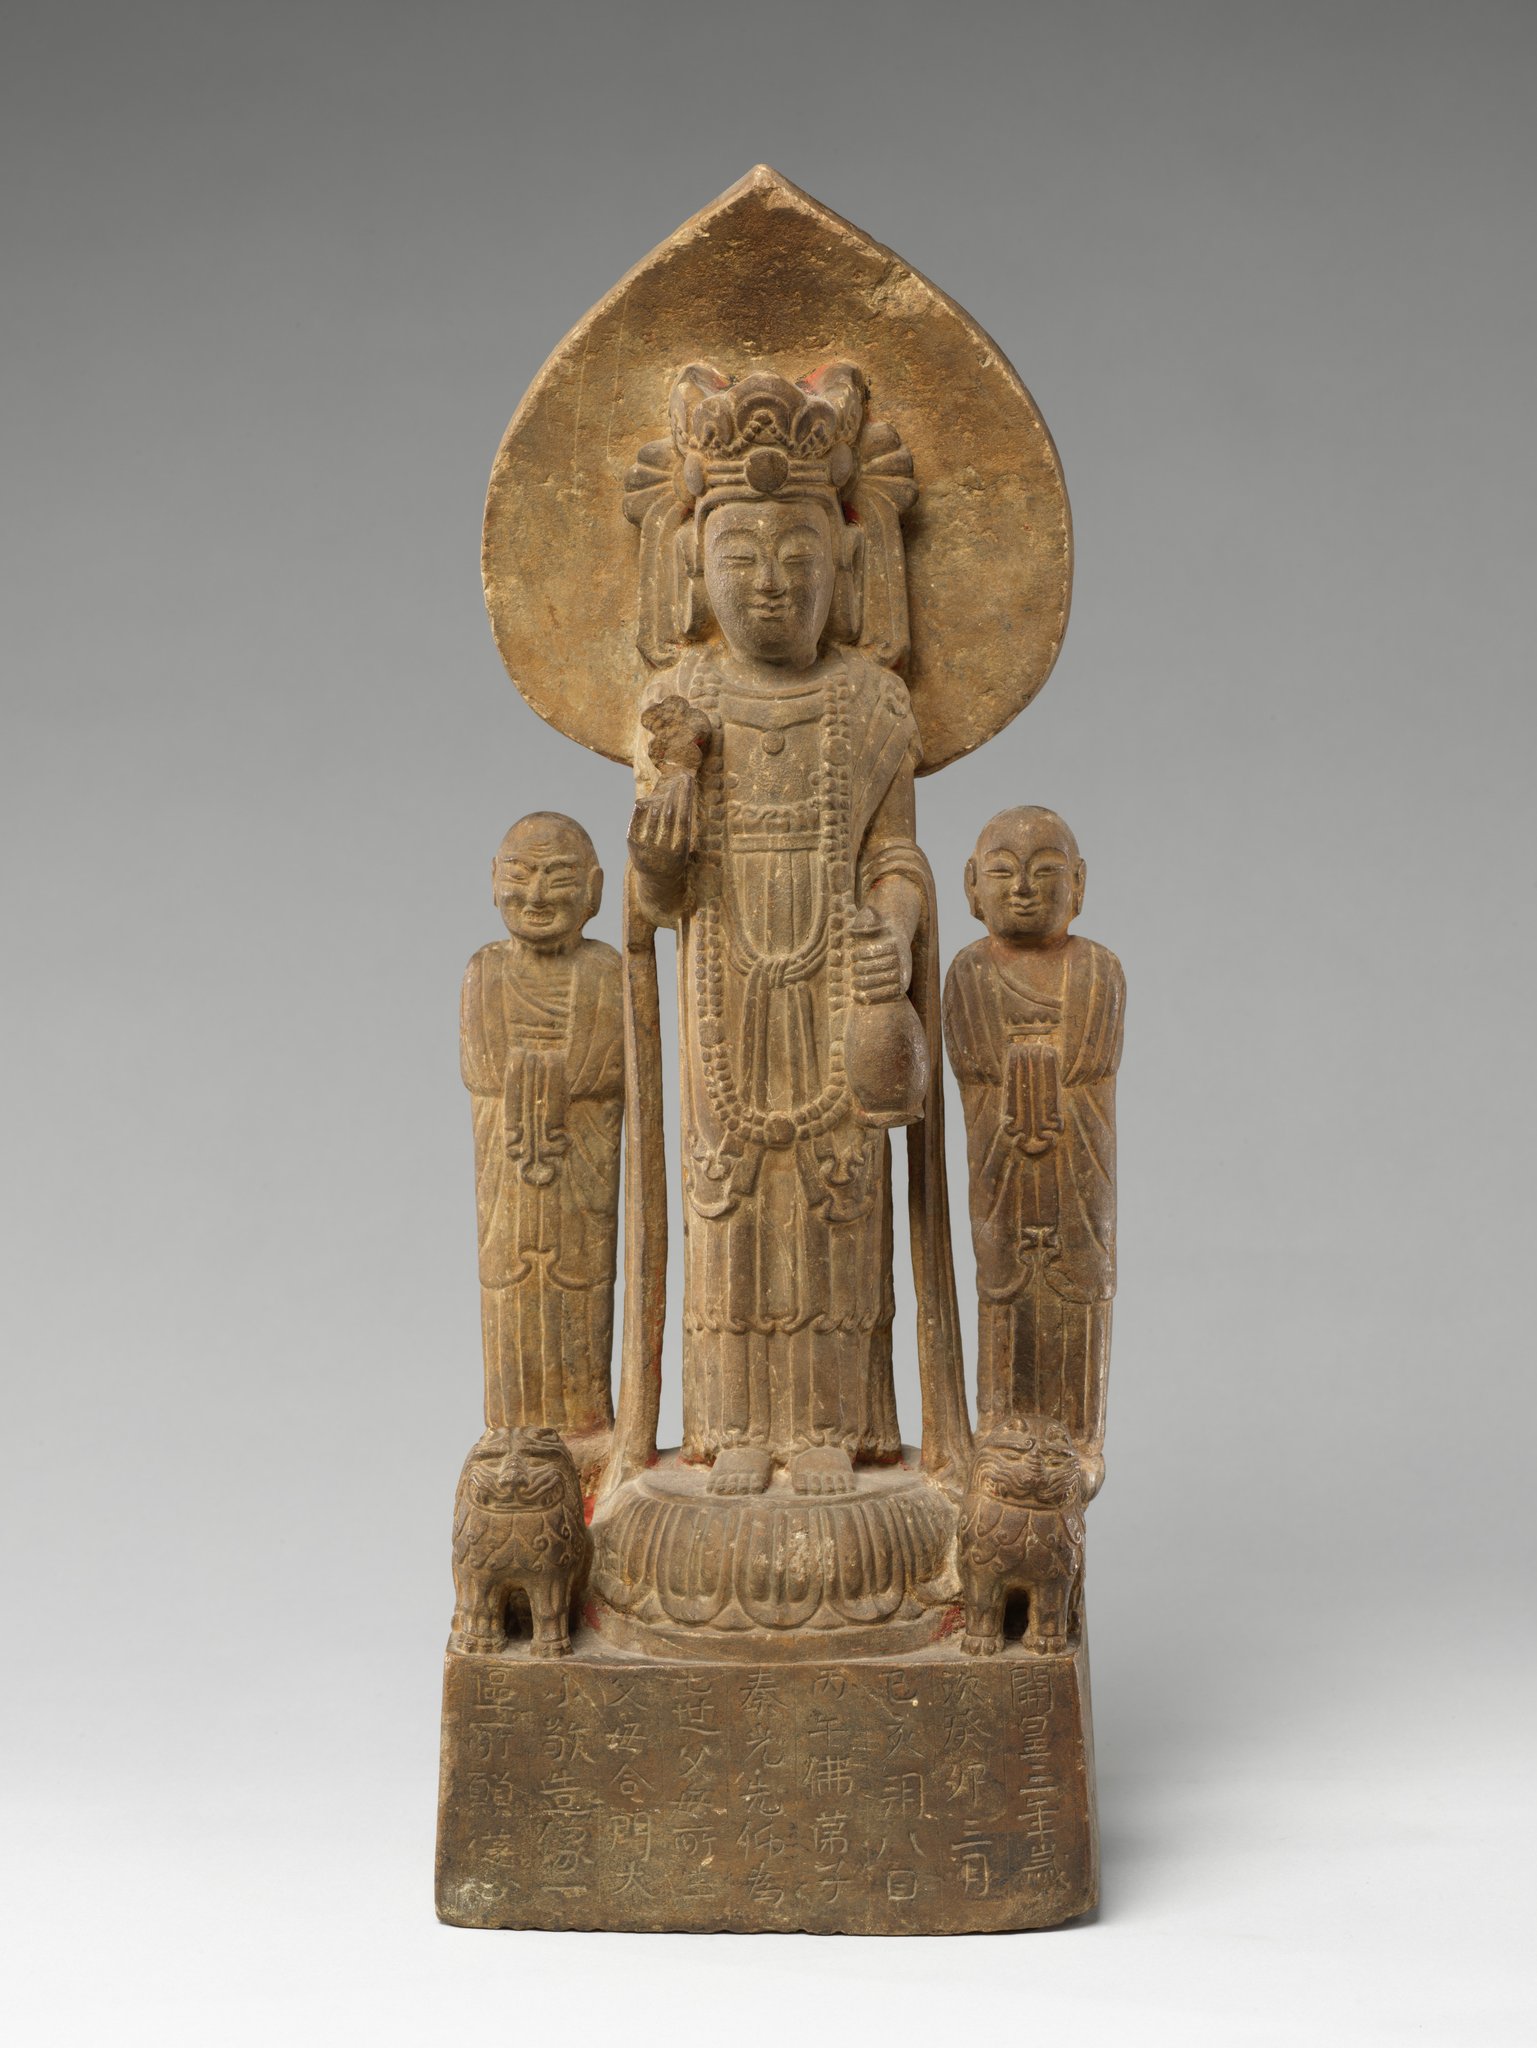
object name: statue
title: Buddha Maitreya with Ananda and Kasyapa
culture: chinese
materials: limestone